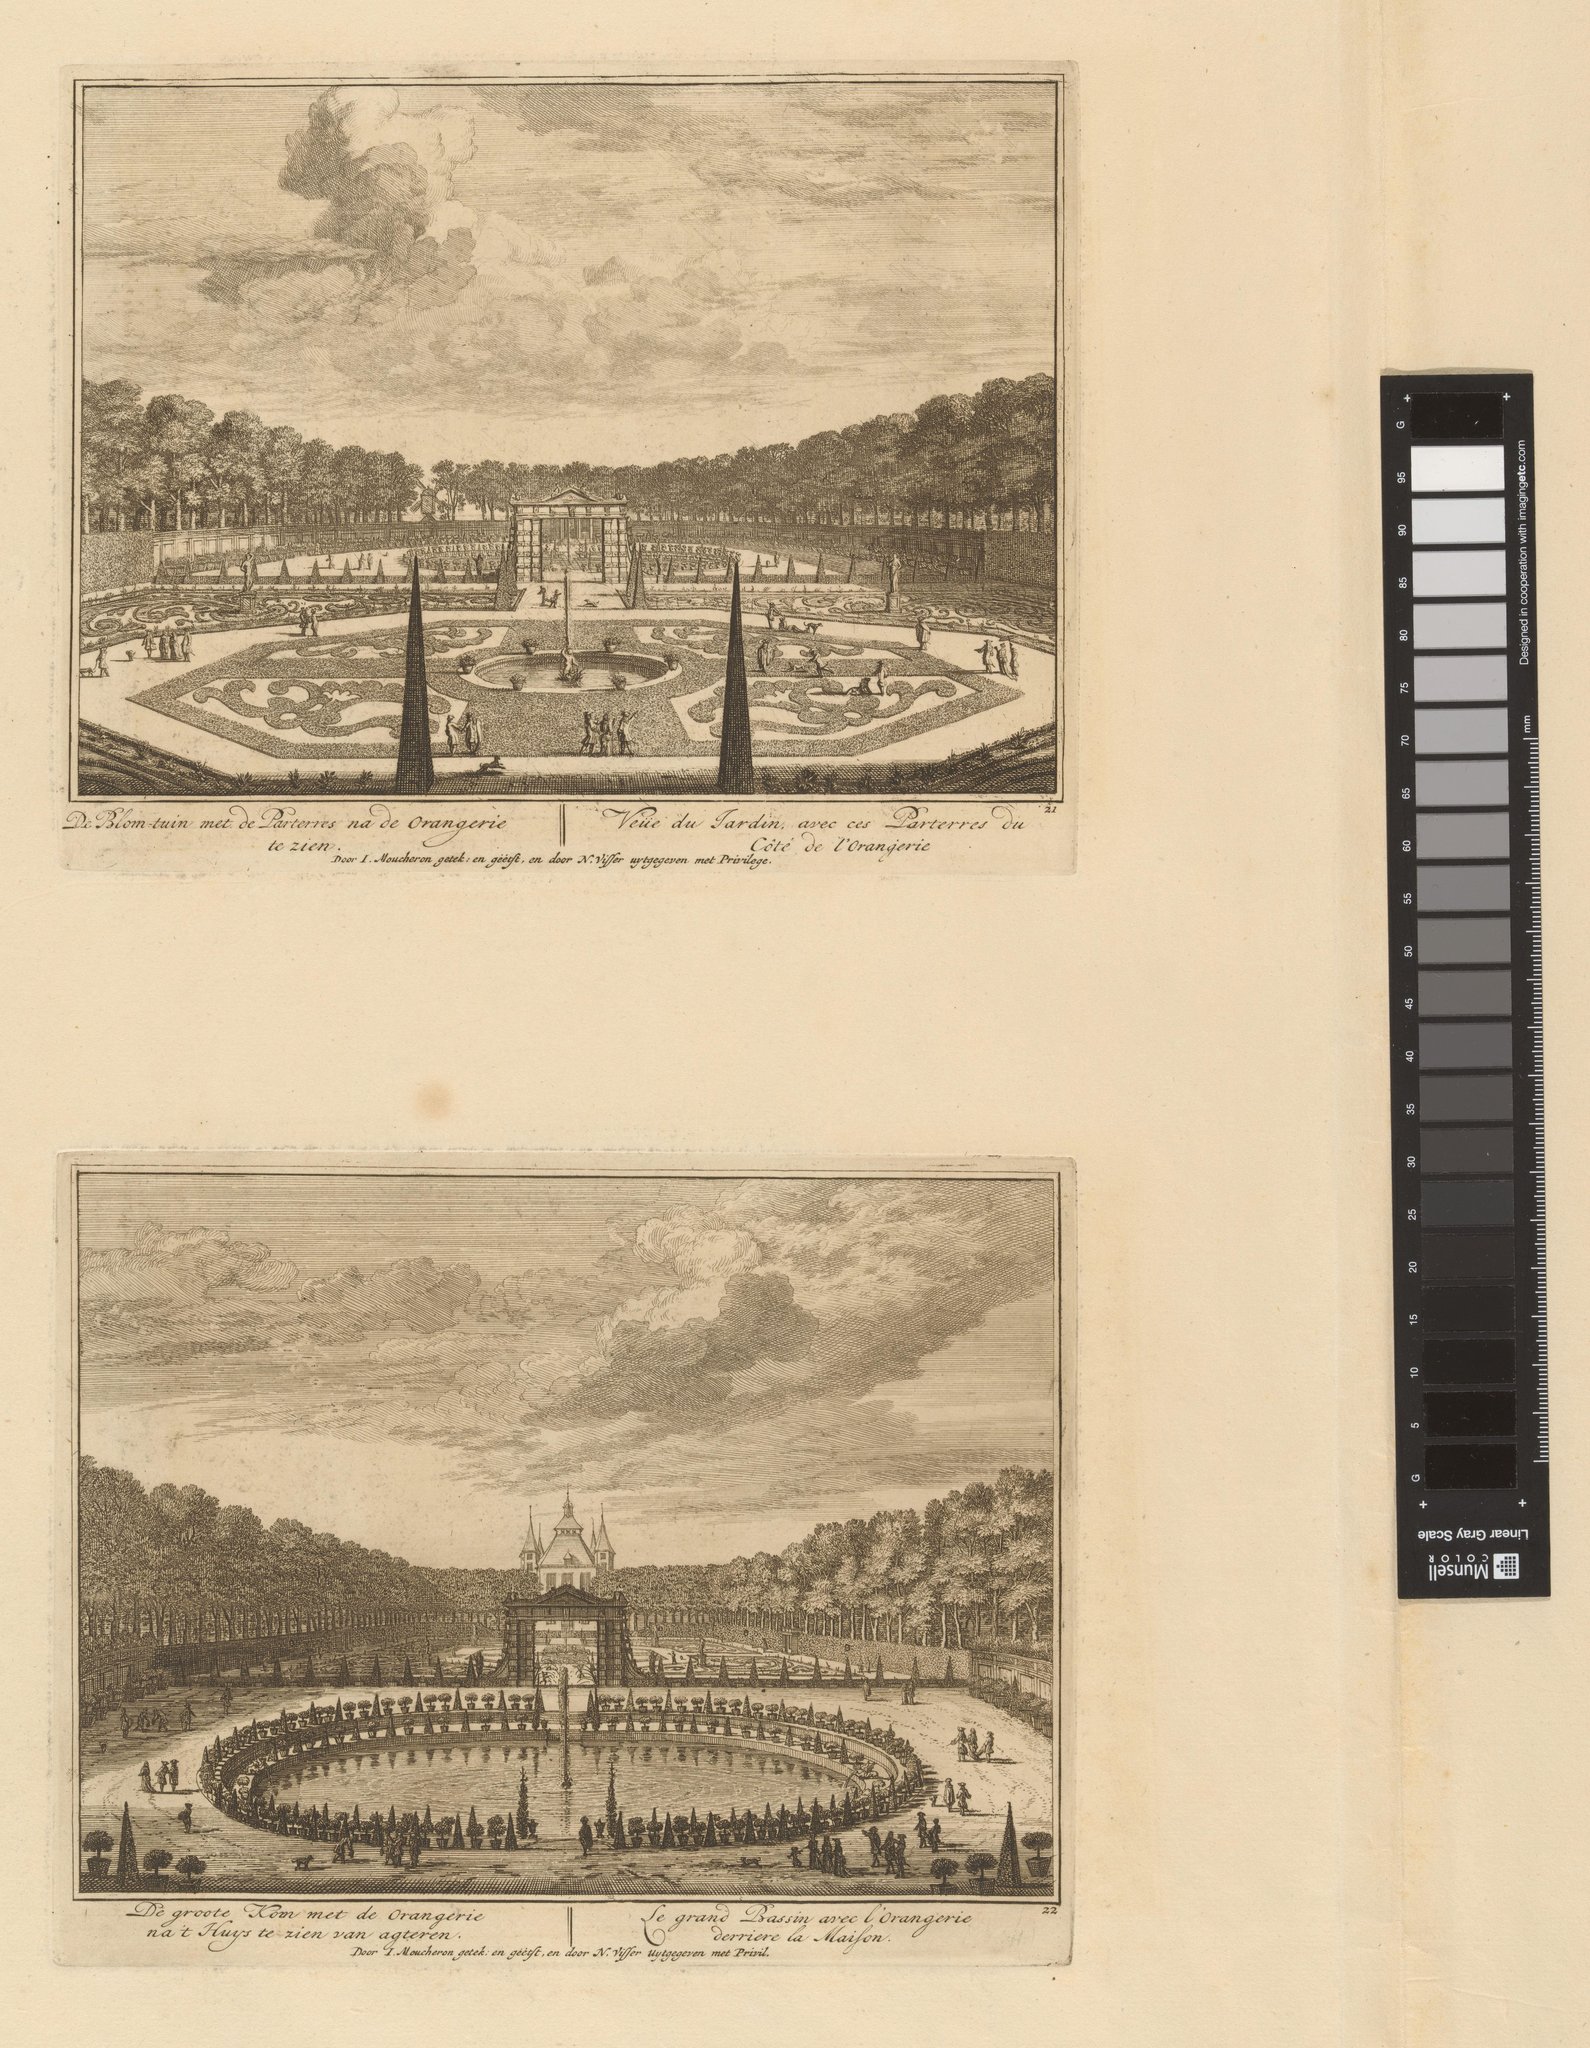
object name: print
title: Gezichten op Kasteel Heemstede in de provincie Utrecht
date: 1706-1719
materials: paper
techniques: engraving, etching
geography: amsterdam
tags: castle, french or architectonic garden; formal garden, artificial grotto in garden, garden pond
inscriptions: collector's mark: Lugt 2228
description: Vier voorstellingen. Linksboven: de bloementuin met parterres en in het midden een fontein bij Kasteel Heemstede. Linksonder: de grote vijver met op de achtergrond Kasteel Heemstede. Rechtsboven: de grot in de tuin van Kasteel Heemstede vanuit de galerij gezien. Rechtsonder: de grot, met in het midden van de vloer een fontein, in de tuin van Kasteel Heemstede.